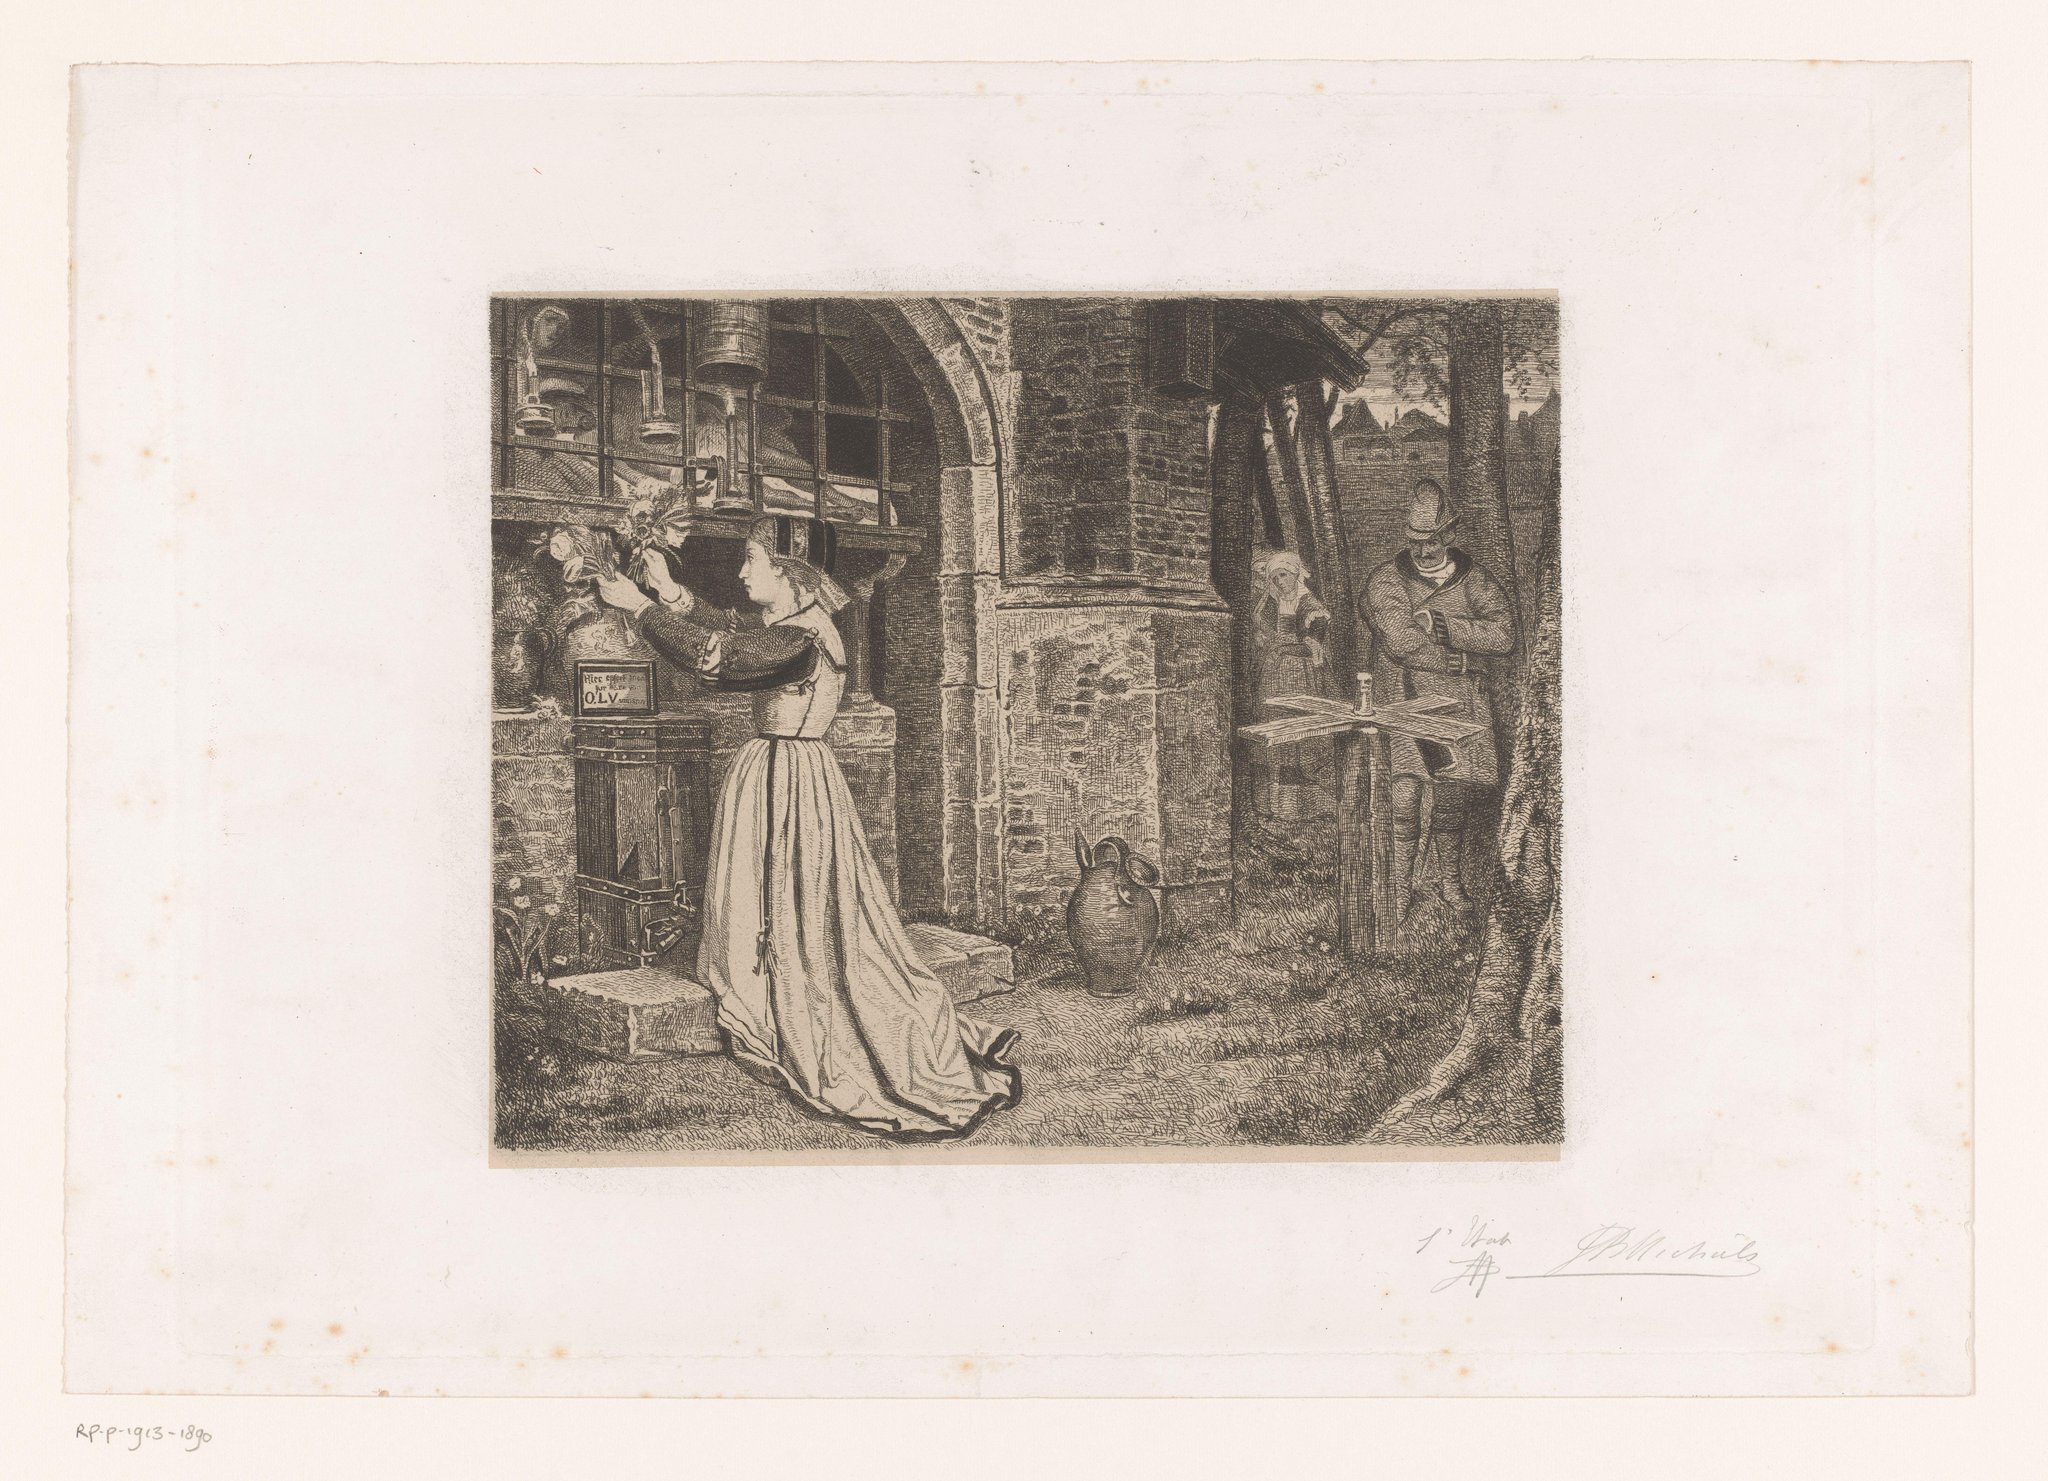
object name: print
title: Faust en Gretchen in een tuin bij een kapel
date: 1831-1890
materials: paper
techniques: etching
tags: faust, (scenes from) specific works of literature: goethe, faust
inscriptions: collector's mark: Lugt 2228, inscription: ‘1e Etat’